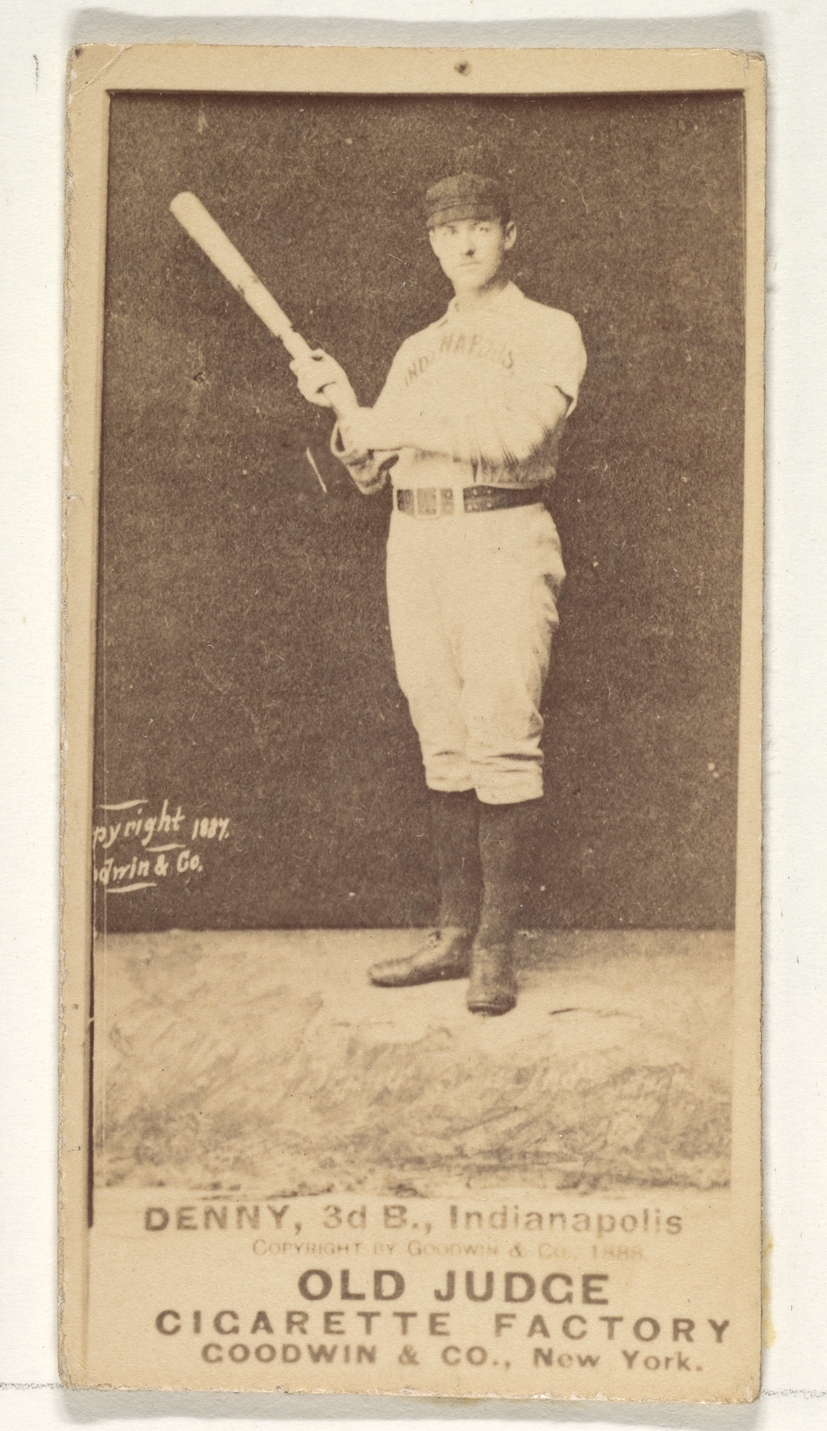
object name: baseball card, photograph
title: Jerry Denny, 3rd Base, Indianapolis, from the Old Judge series (N172) for Old Judge Cigarettes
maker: goodwin & company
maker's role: publisher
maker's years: 1850-1950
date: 1888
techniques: albumen silver print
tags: men,portraits,baseball,athletes